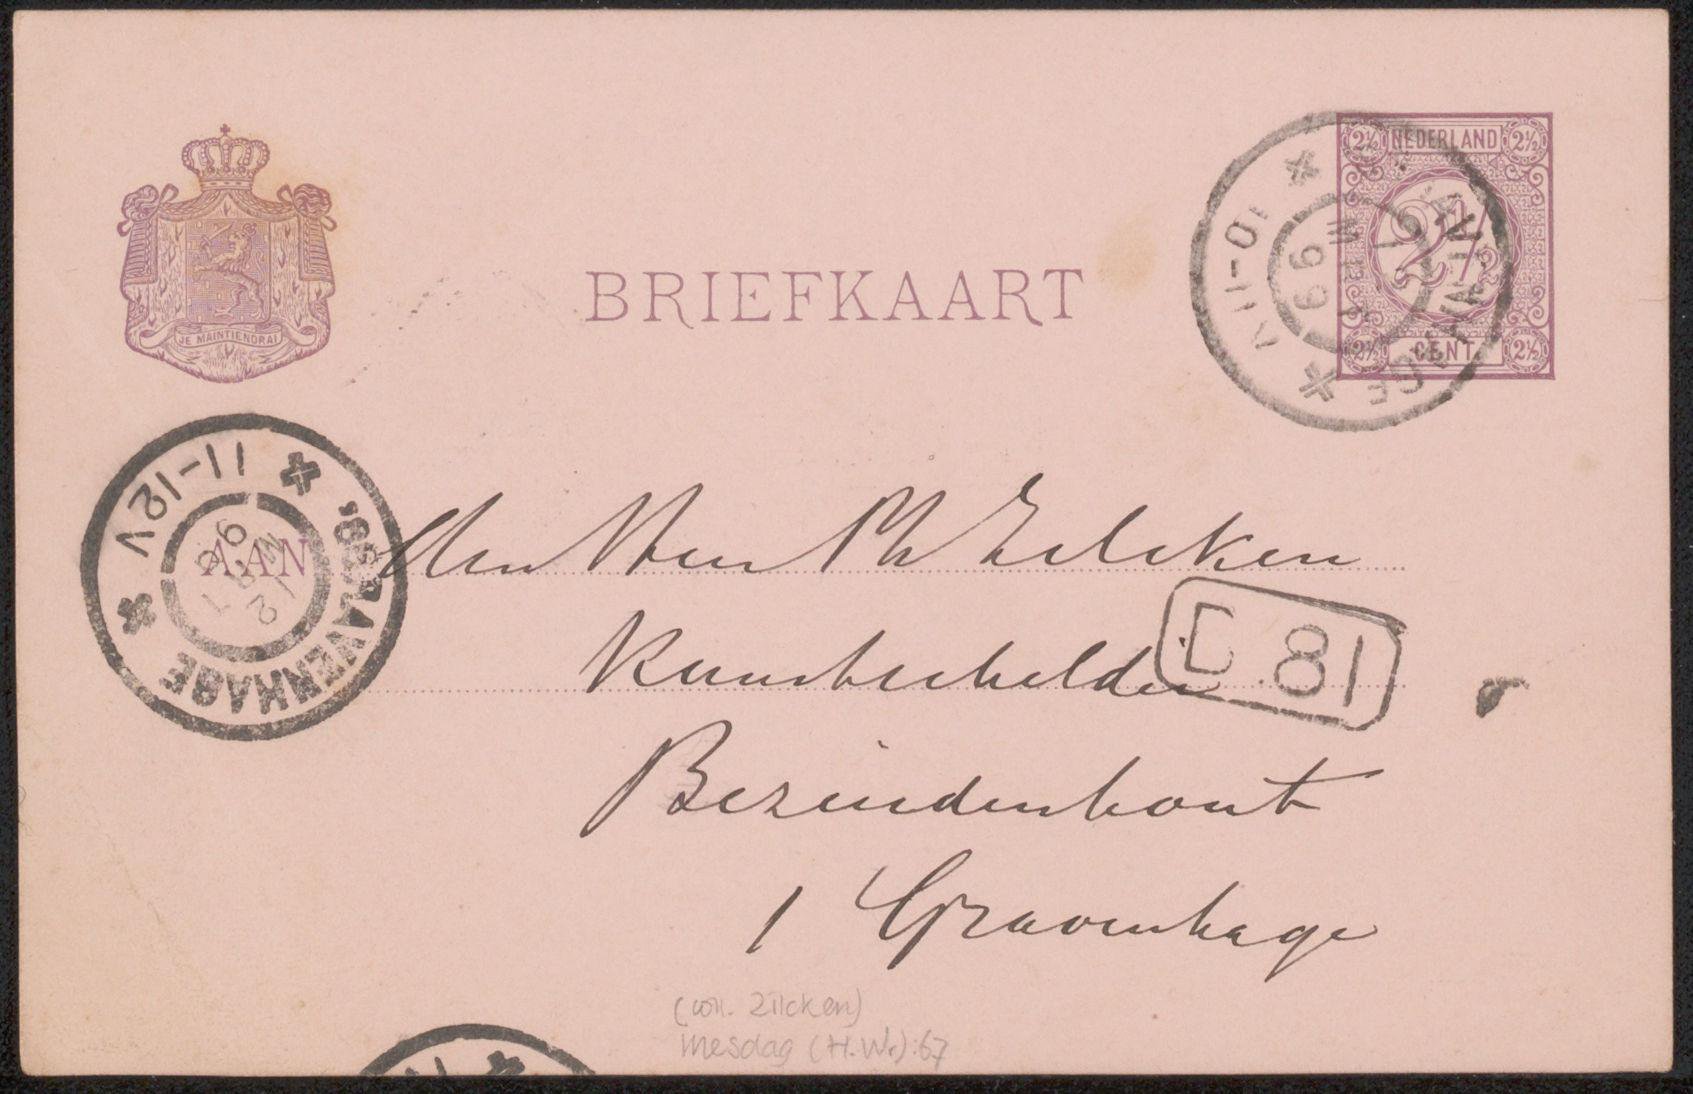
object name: postcard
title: Briefkaart aan Philip Zilcken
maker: hendrik willem mesdag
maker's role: draughtsman, painter, print maker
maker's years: 1831-1915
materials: cardboard, ink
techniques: pen, writing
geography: the hague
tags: painter, philip zilcken, the graphic arts, painting (including book-illumination, miniature-painting), printed matter